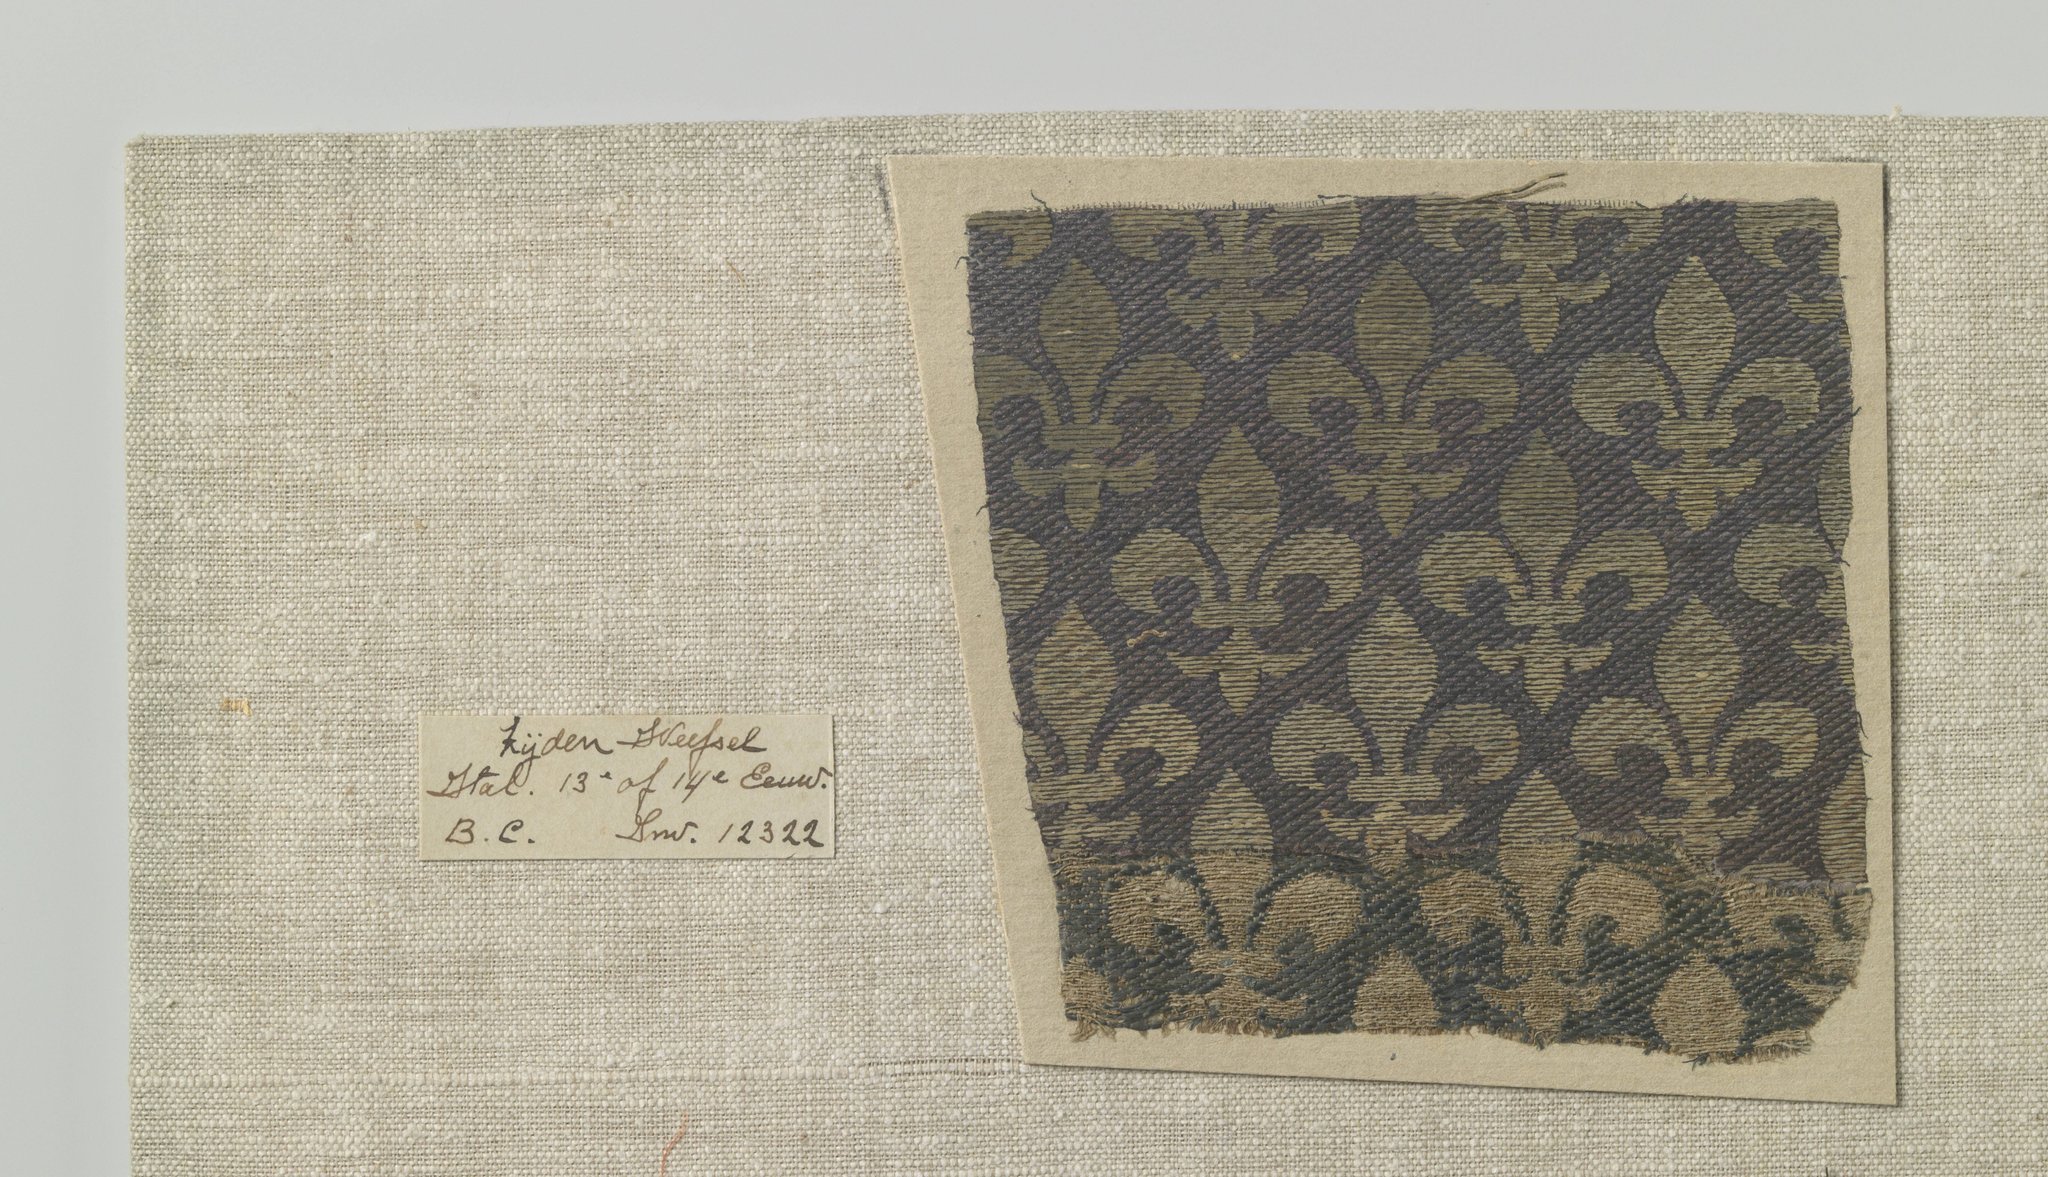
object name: fragment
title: Fragment blauw samiet met patroon van fleurs-de-lis in goud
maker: paul schulze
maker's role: museumdirecteur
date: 1200-1399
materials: metal thread, silk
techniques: samite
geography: krefeld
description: Langwerpig fragment blauw samiet met een patroon in goud van dicht opeenstaande fleurs-de-lis in diagonale rijen. Het fragment is bevestigd op een stuk karton en het patroon is aangevuld met schilderwerk.